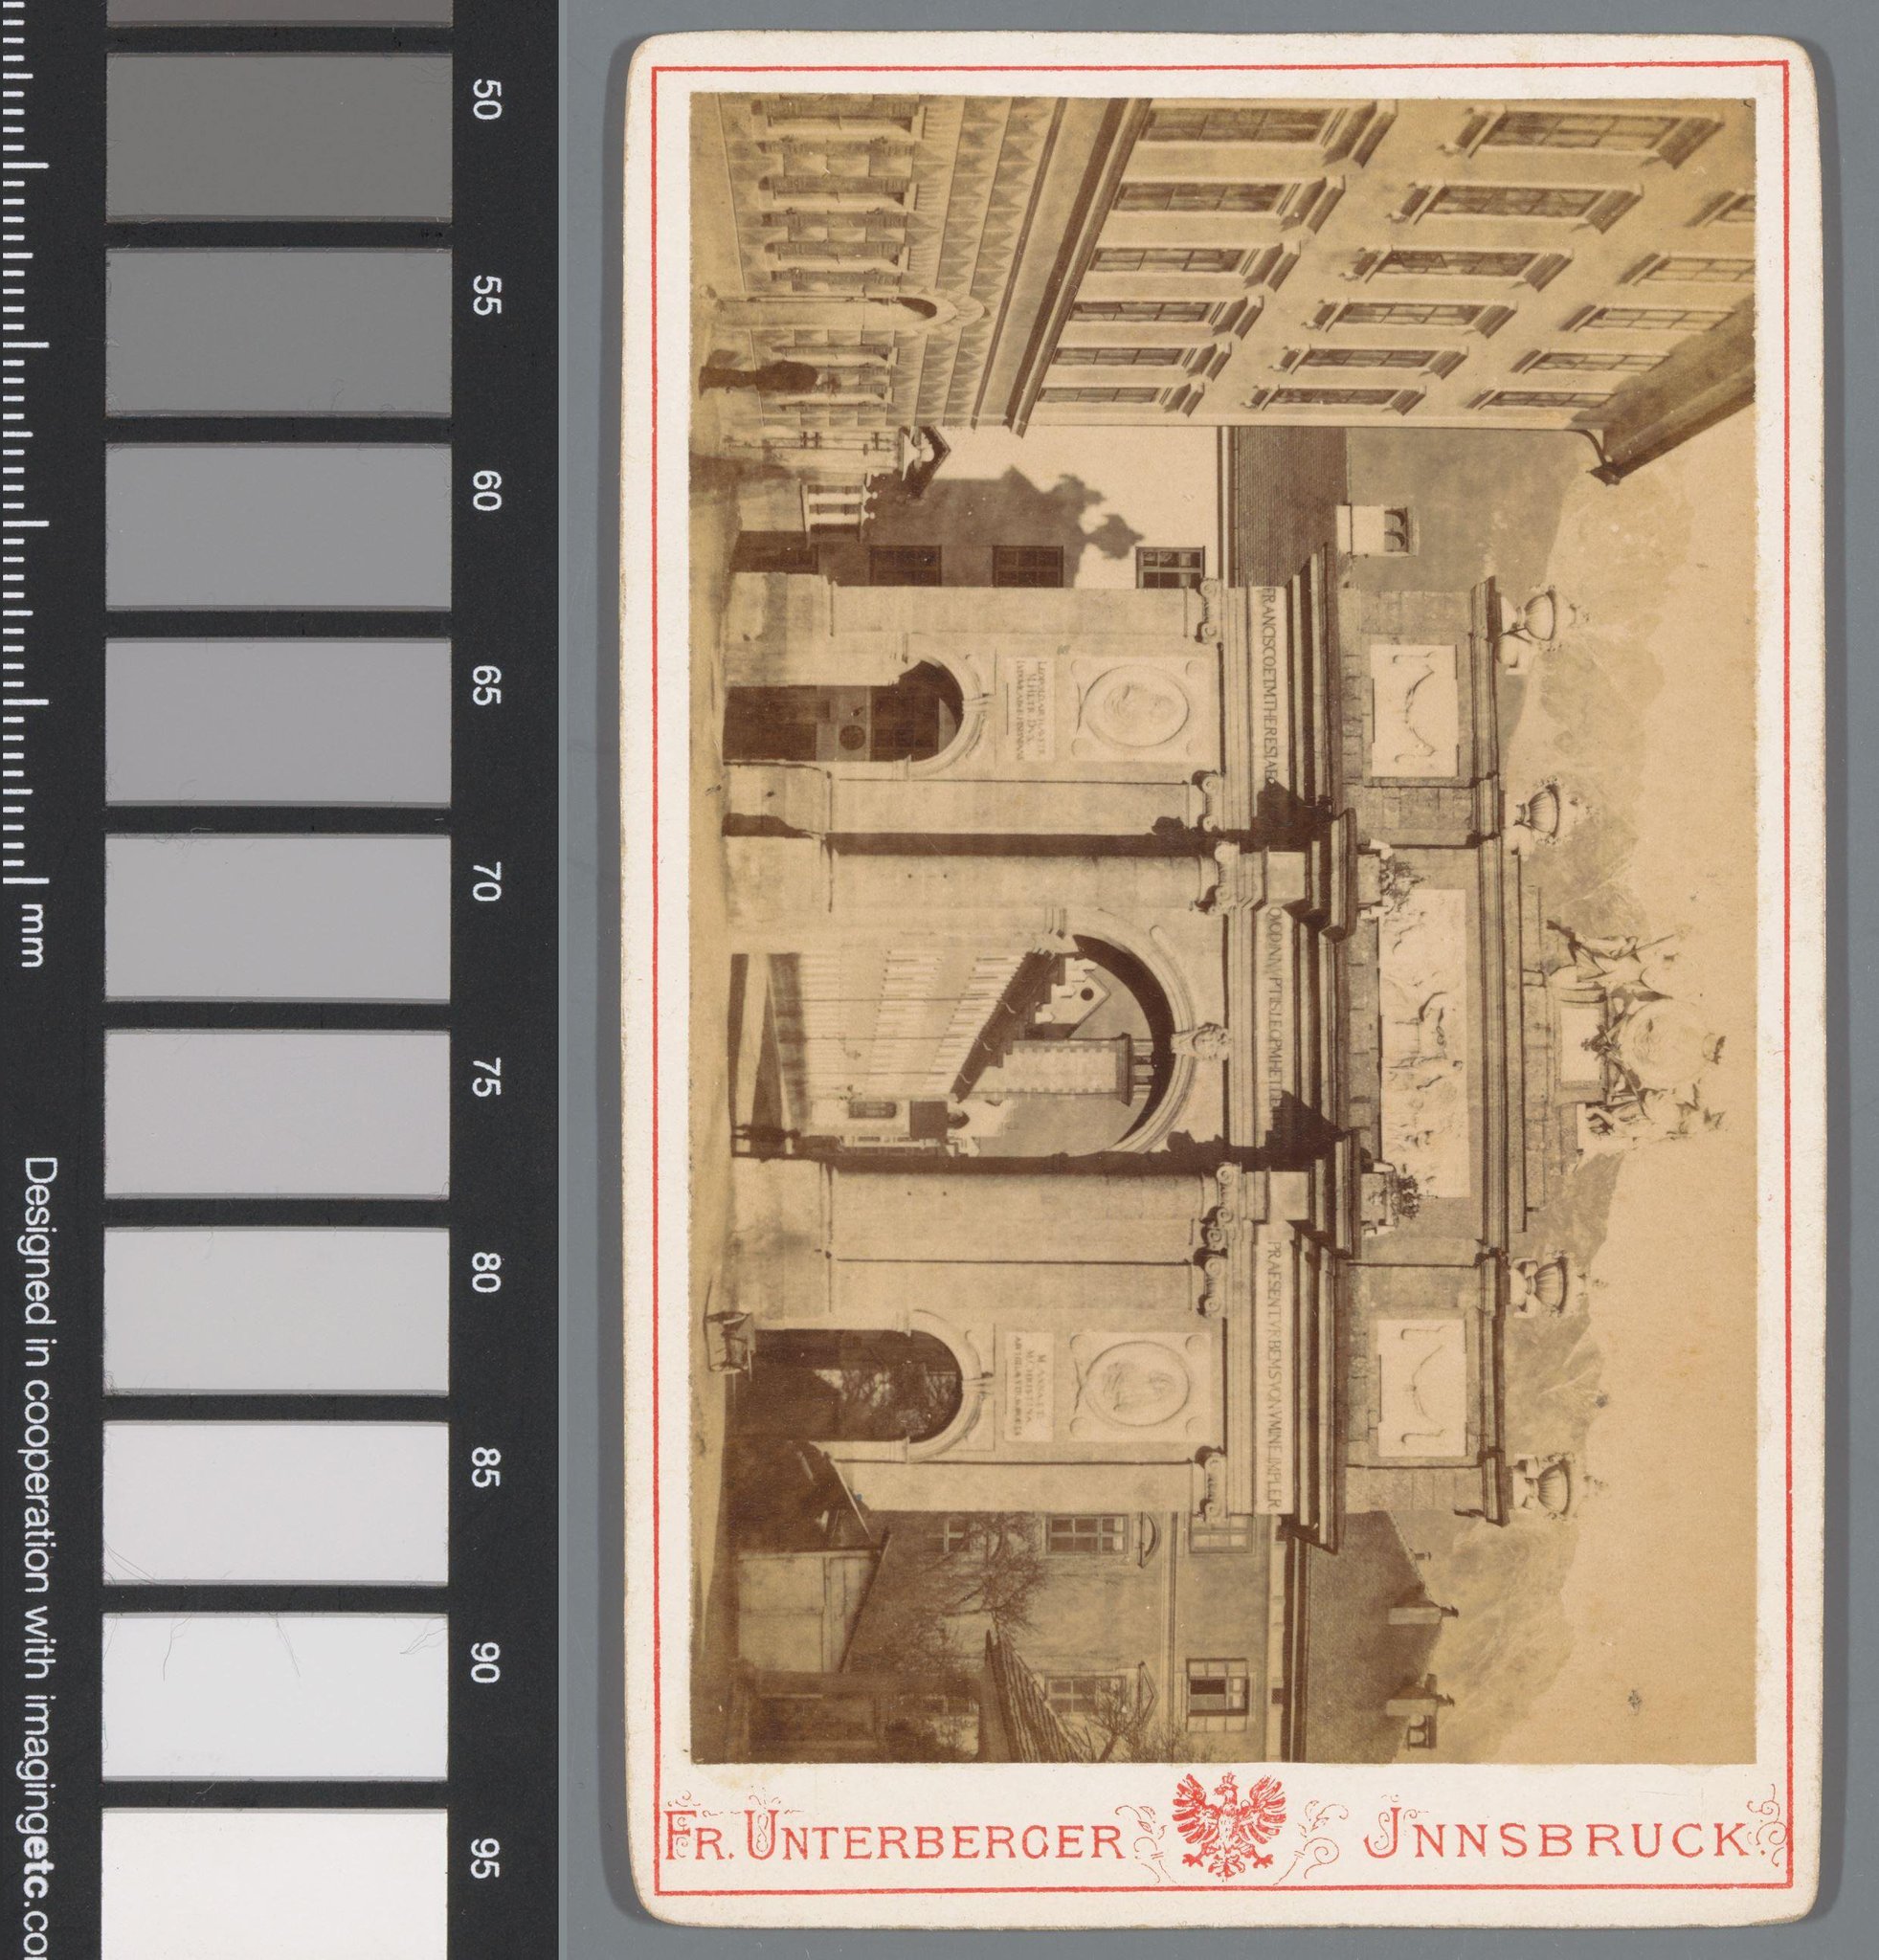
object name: carte de visite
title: Triumphbogen in Innsbruck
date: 1855-1867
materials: cardboard, paper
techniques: albumen print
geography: innsbruck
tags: triumphal arch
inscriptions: number: ‘6.’, inscription: ‘Fr. Unterberger/ Innsbruck’